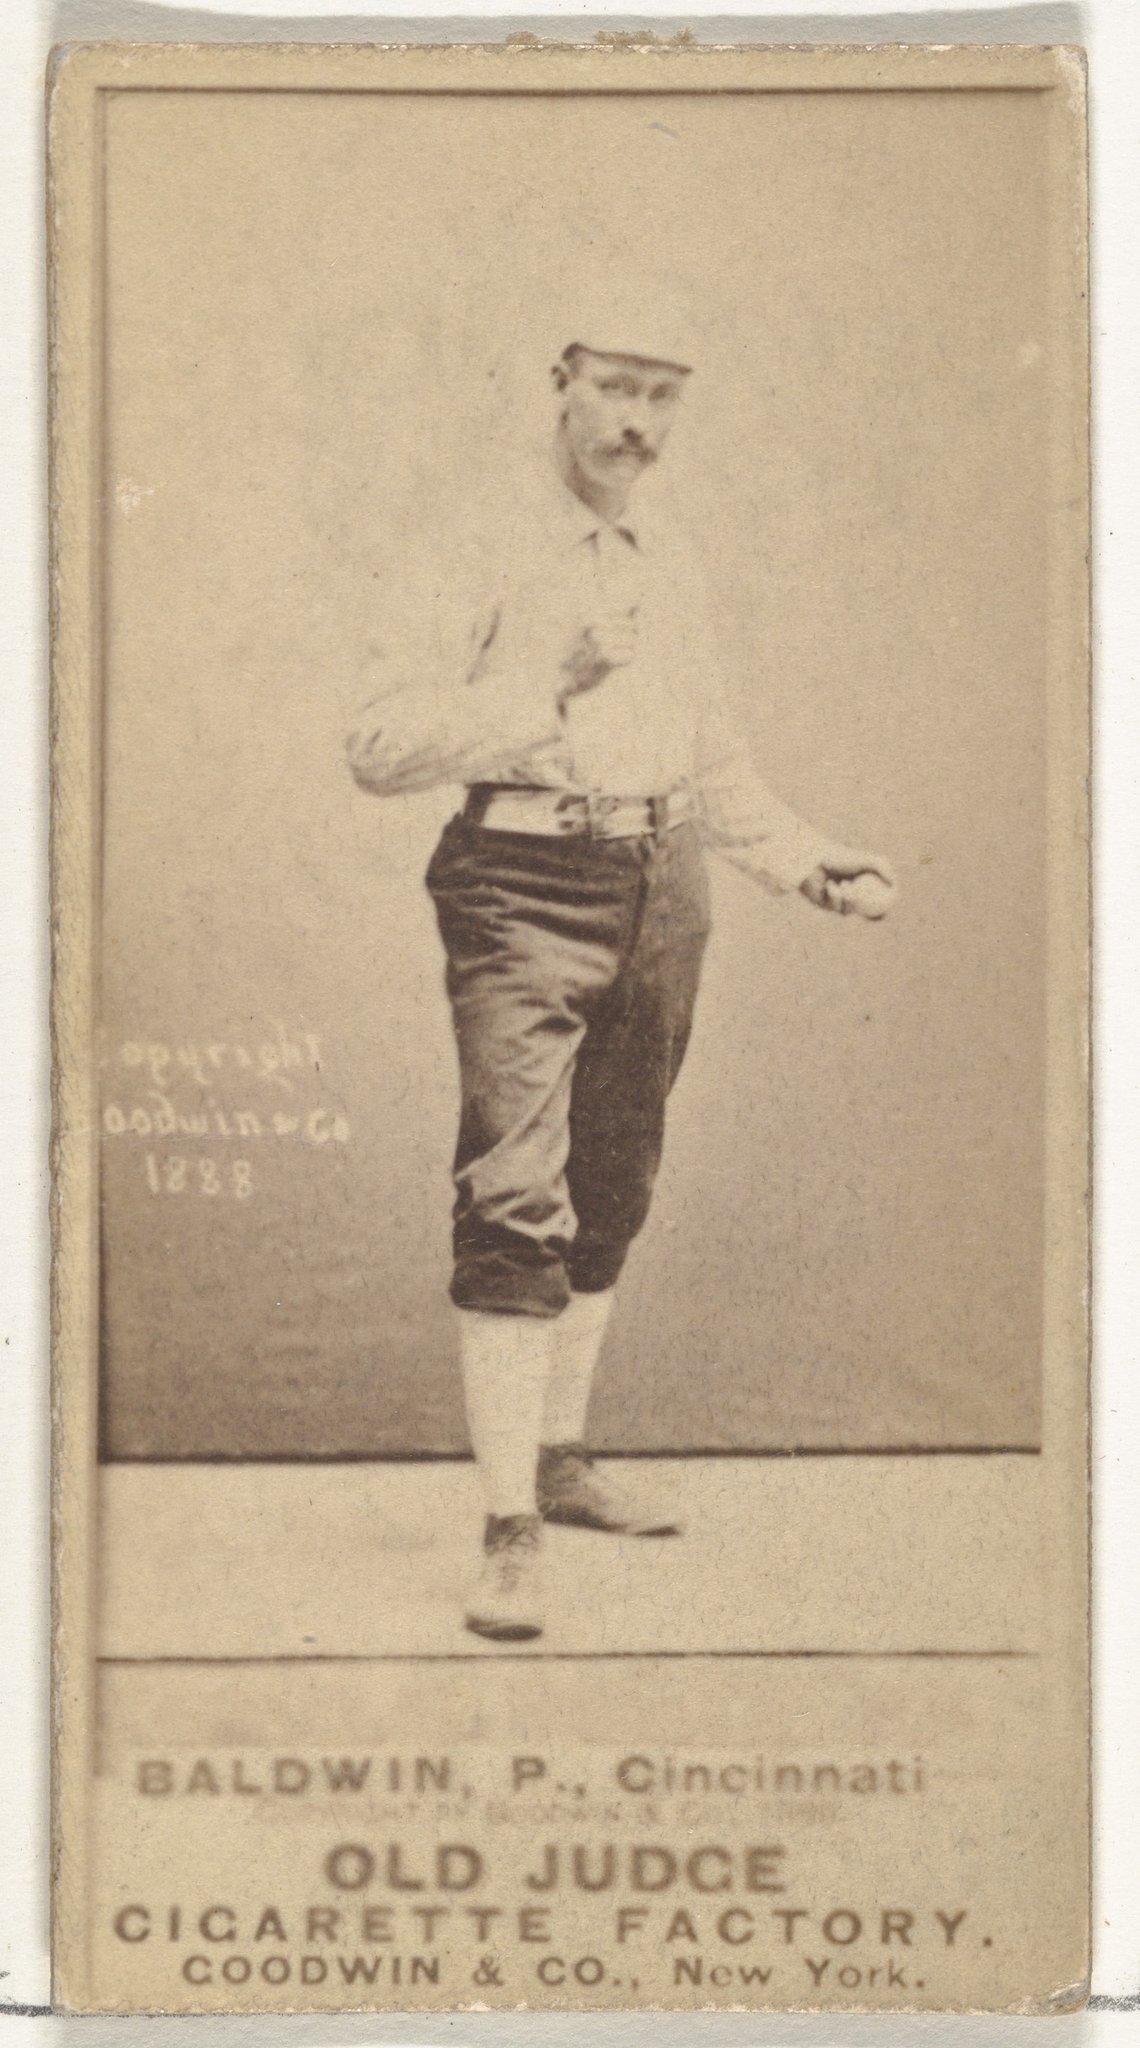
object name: baseball card, photograph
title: Clarence Geoghan "Kid" Baldwin, Catcher, Cincinnati, from the Old Judge series (N172) for Old Judge Cigarettes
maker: goodwin & company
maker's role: publisher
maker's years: 1850-1950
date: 1888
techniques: albumen silver print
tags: men,portraits,baseball,athletes